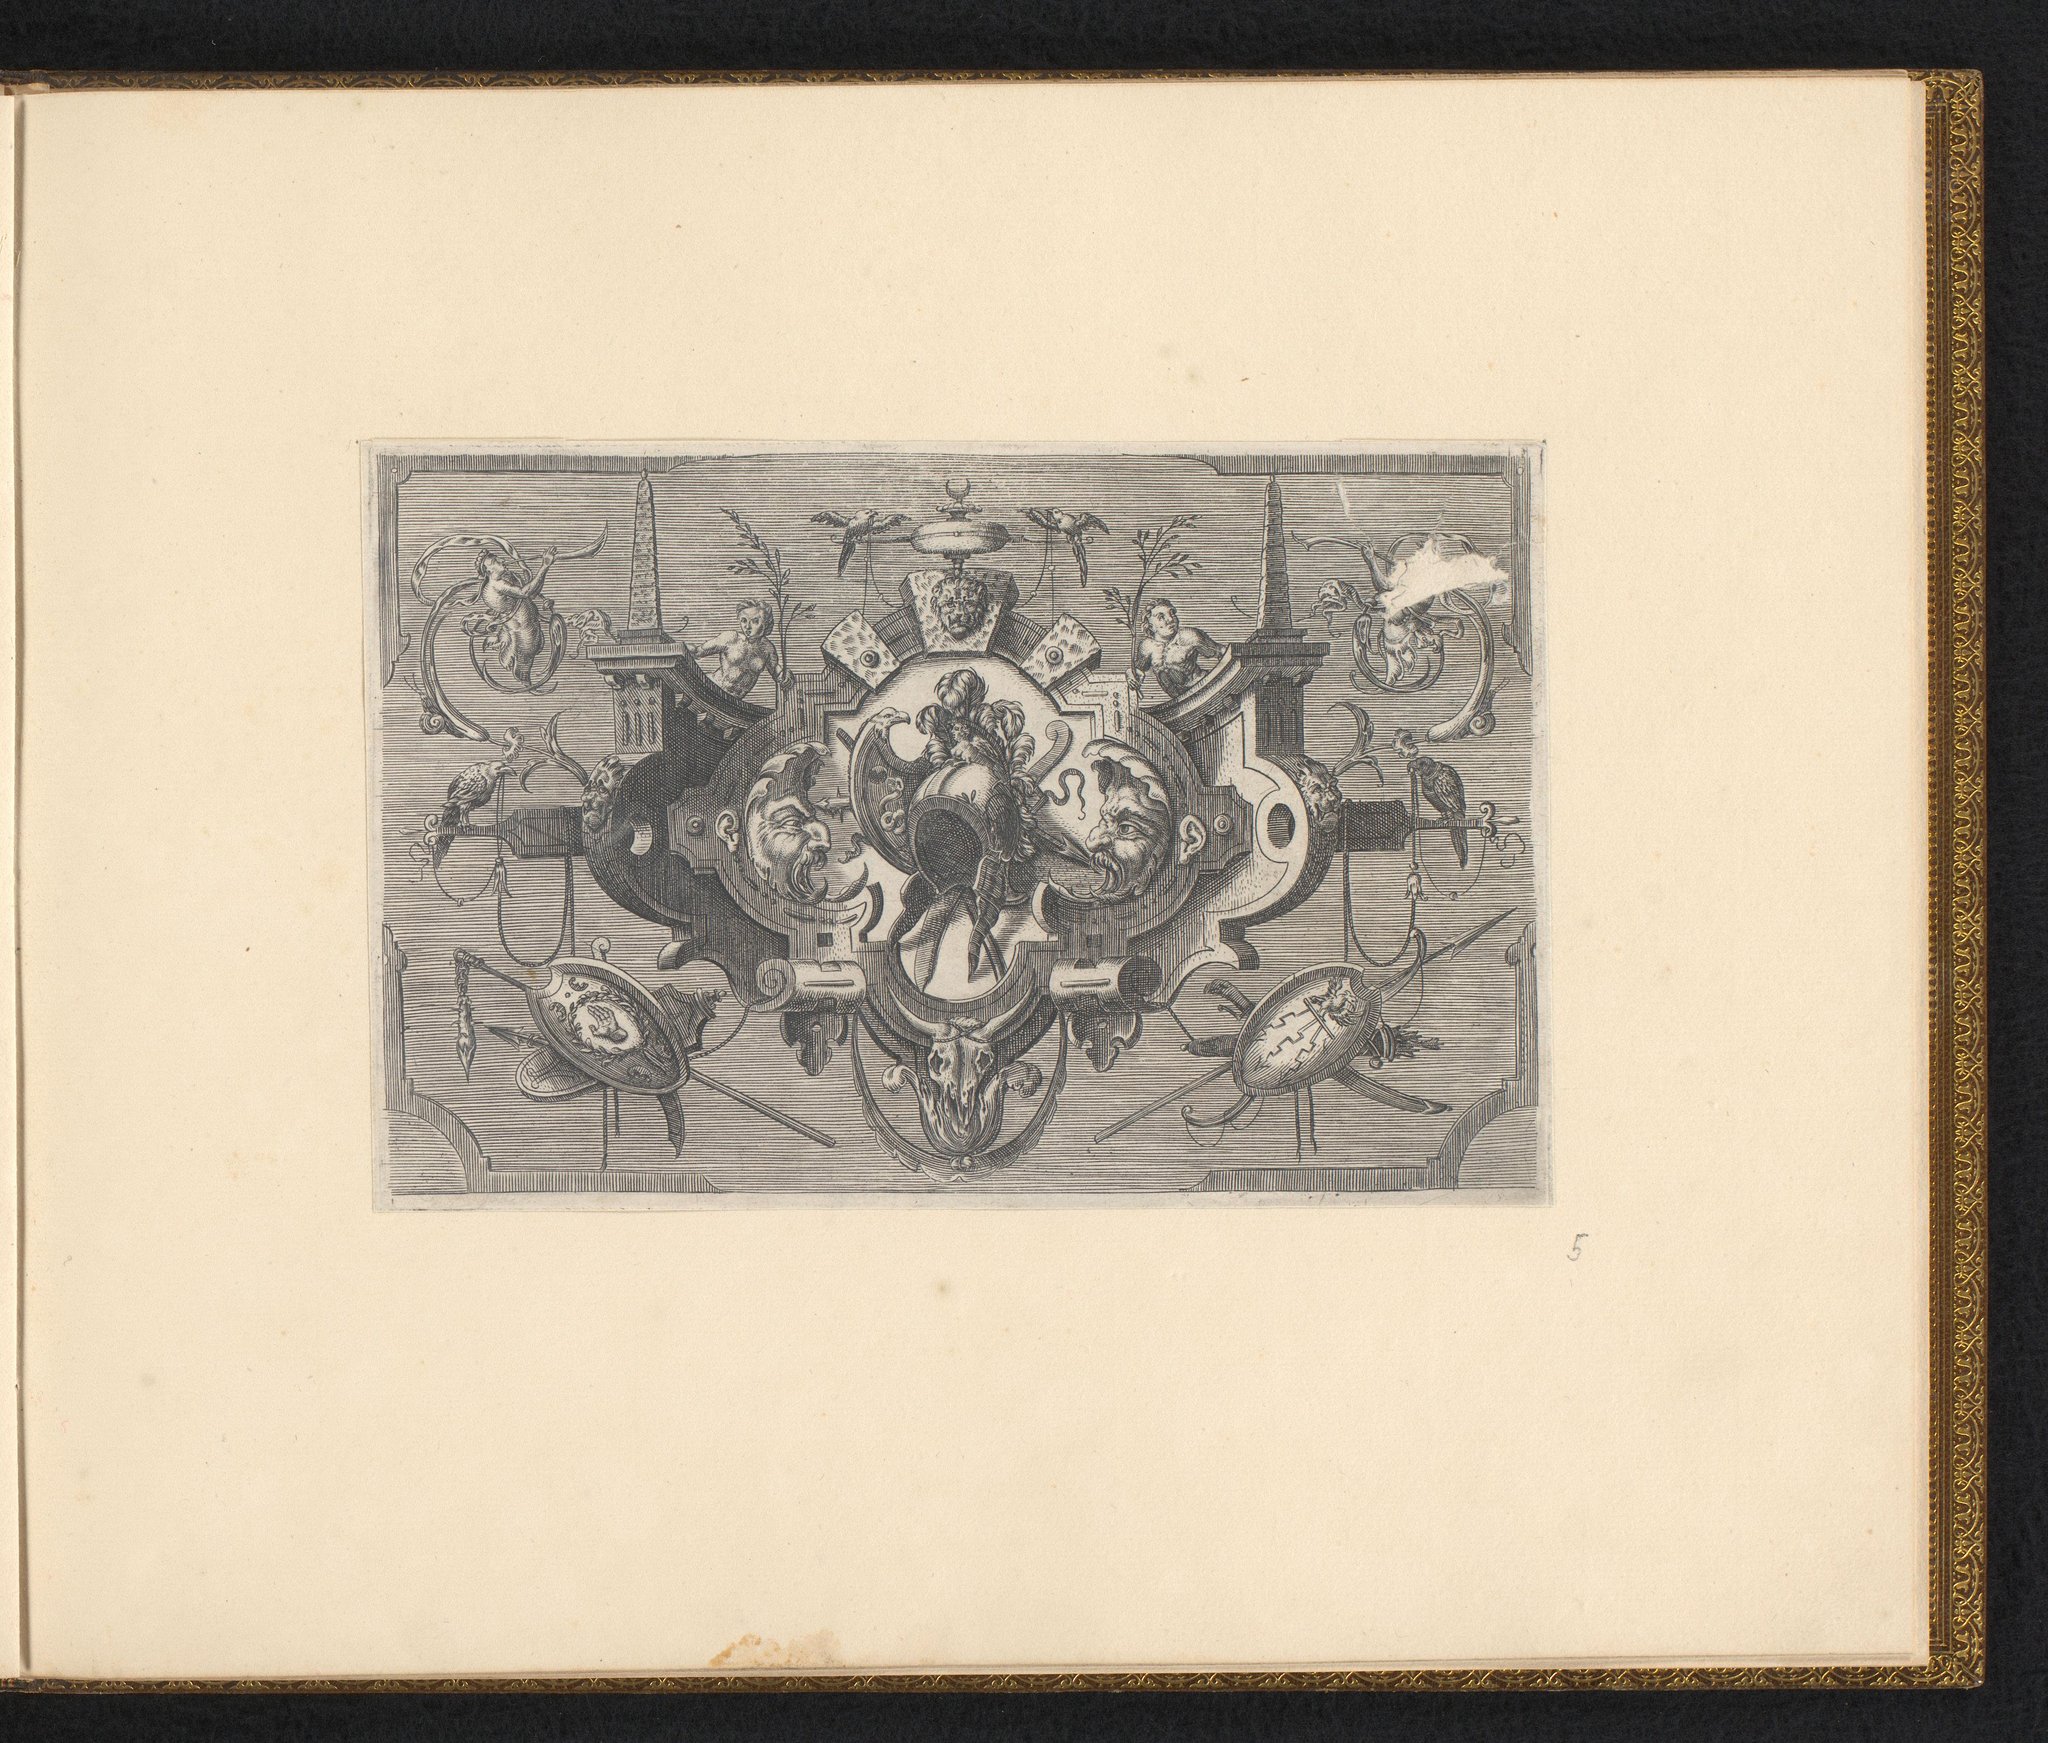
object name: album leaf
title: Veelderhande cierlijcke compertementen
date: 1564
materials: paper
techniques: engraving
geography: antwerp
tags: 'tropaion', i.e. decorative ornament ~ weapons, scrollwork, strapwork ~ ornament, birds, ornament ~ cartouche, mask, mascaron ~ ornament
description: Cartouche met een wapentrofee geflankeerd door twee mascarons en profil. De oren van de mascerons steken uit het rolwerk van de omlijsting. Links- en rechtsboven een manfiguur blazend op een loftrompet. Links- en rechtsonder een wapentrofee. De prent maakt deel uit van een album.